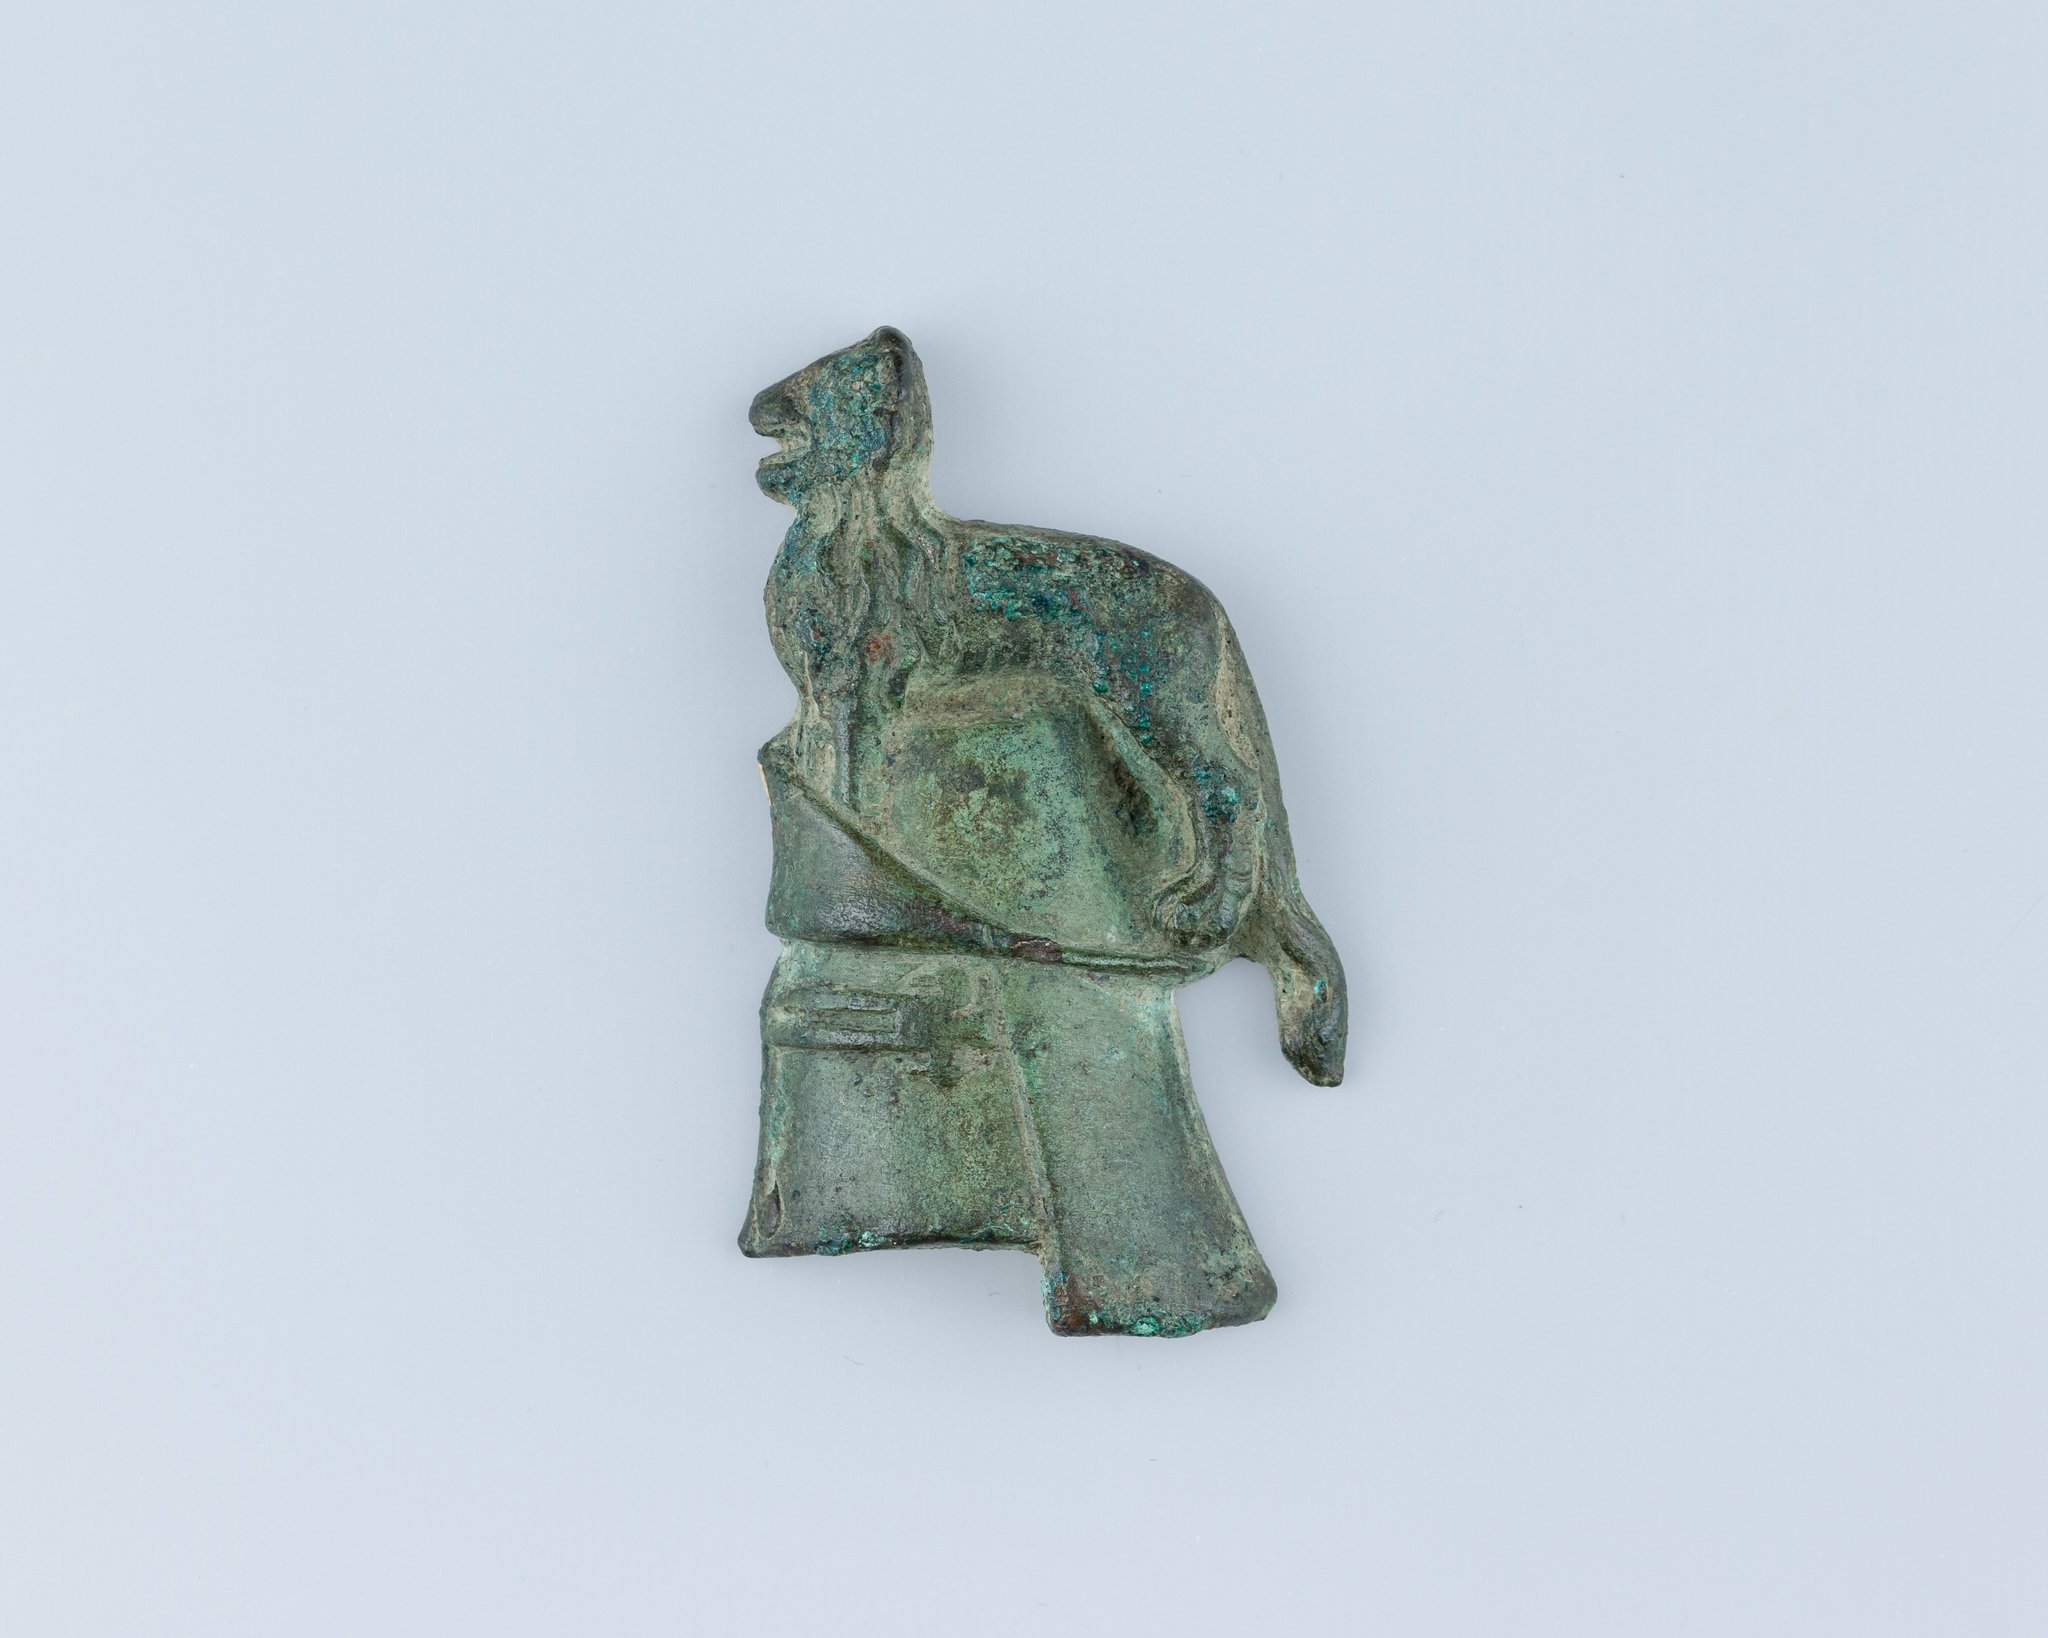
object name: ornament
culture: british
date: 1301-1400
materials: bronze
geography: england